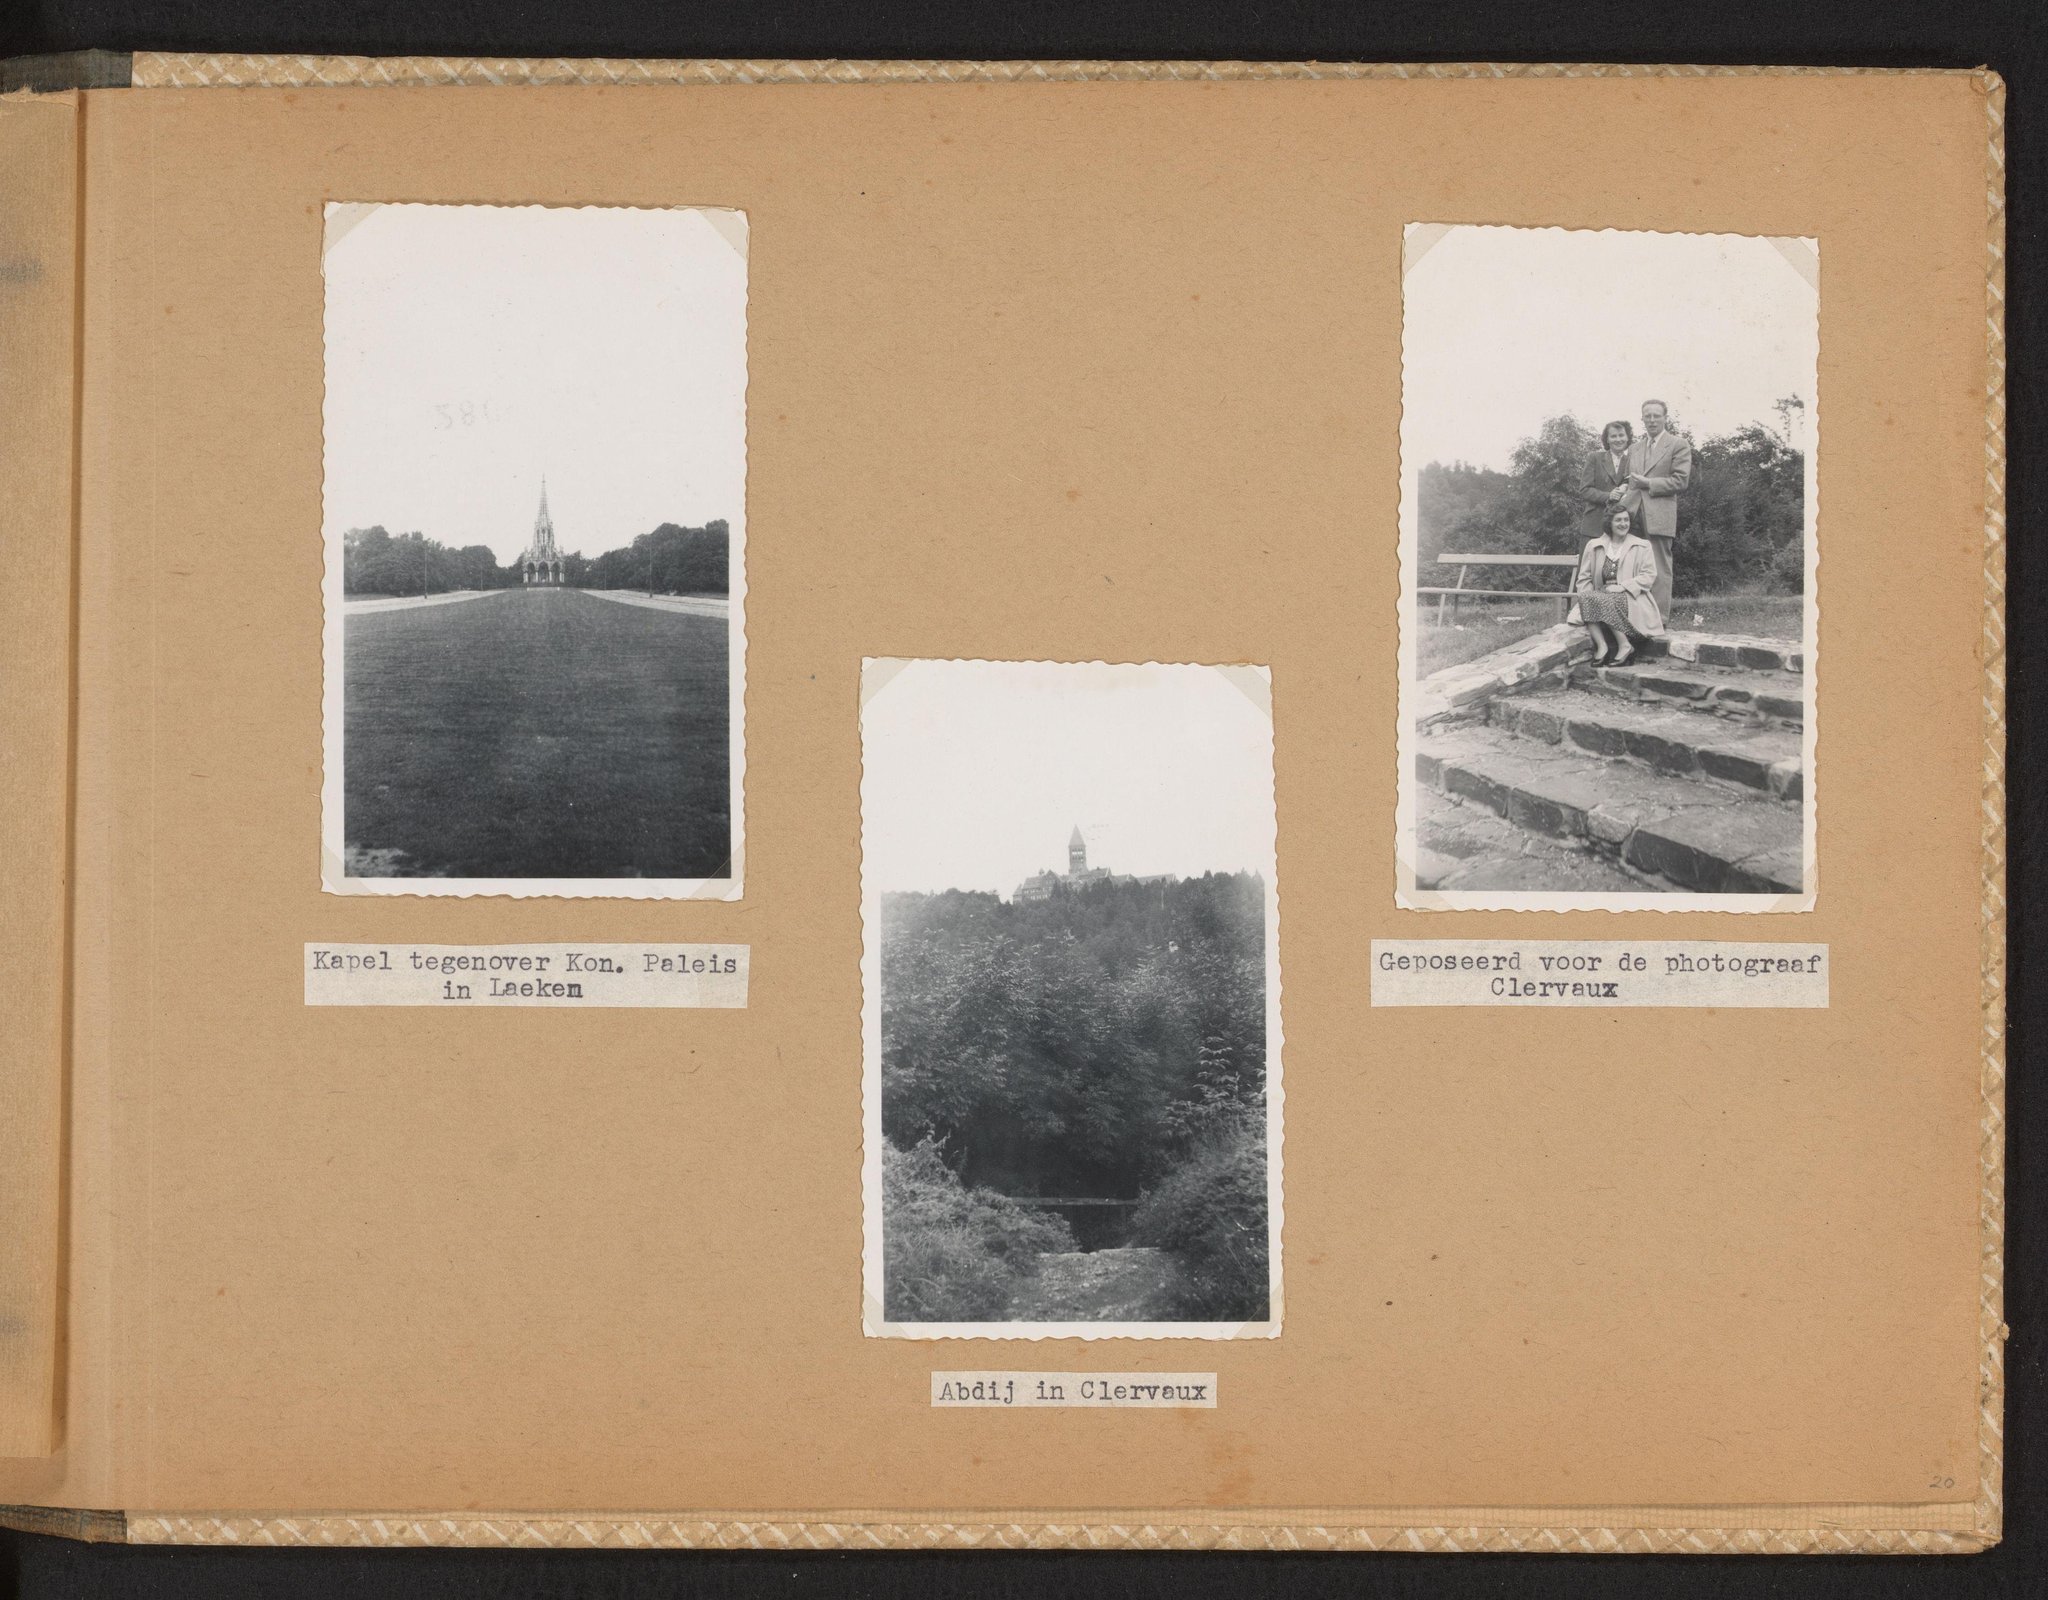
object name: album leaf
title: Laken en Clervaux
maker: Anonymous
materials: paper, photographic support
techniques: gelatin silver print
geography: belgium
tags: the family travelling, on holiday, outing, pleasure trip, laeken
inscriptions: inscription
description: Albumblad met drie foto's met gezichten te Laken en Clervaux. Onder de foto's uitgeknipte papiertjes met getypte opschriften. Onderdeel van het tweede fotoalbum met foto's van familievakanties in Nederland, België, Luxemburg en Frankrijk in 1950-1951.